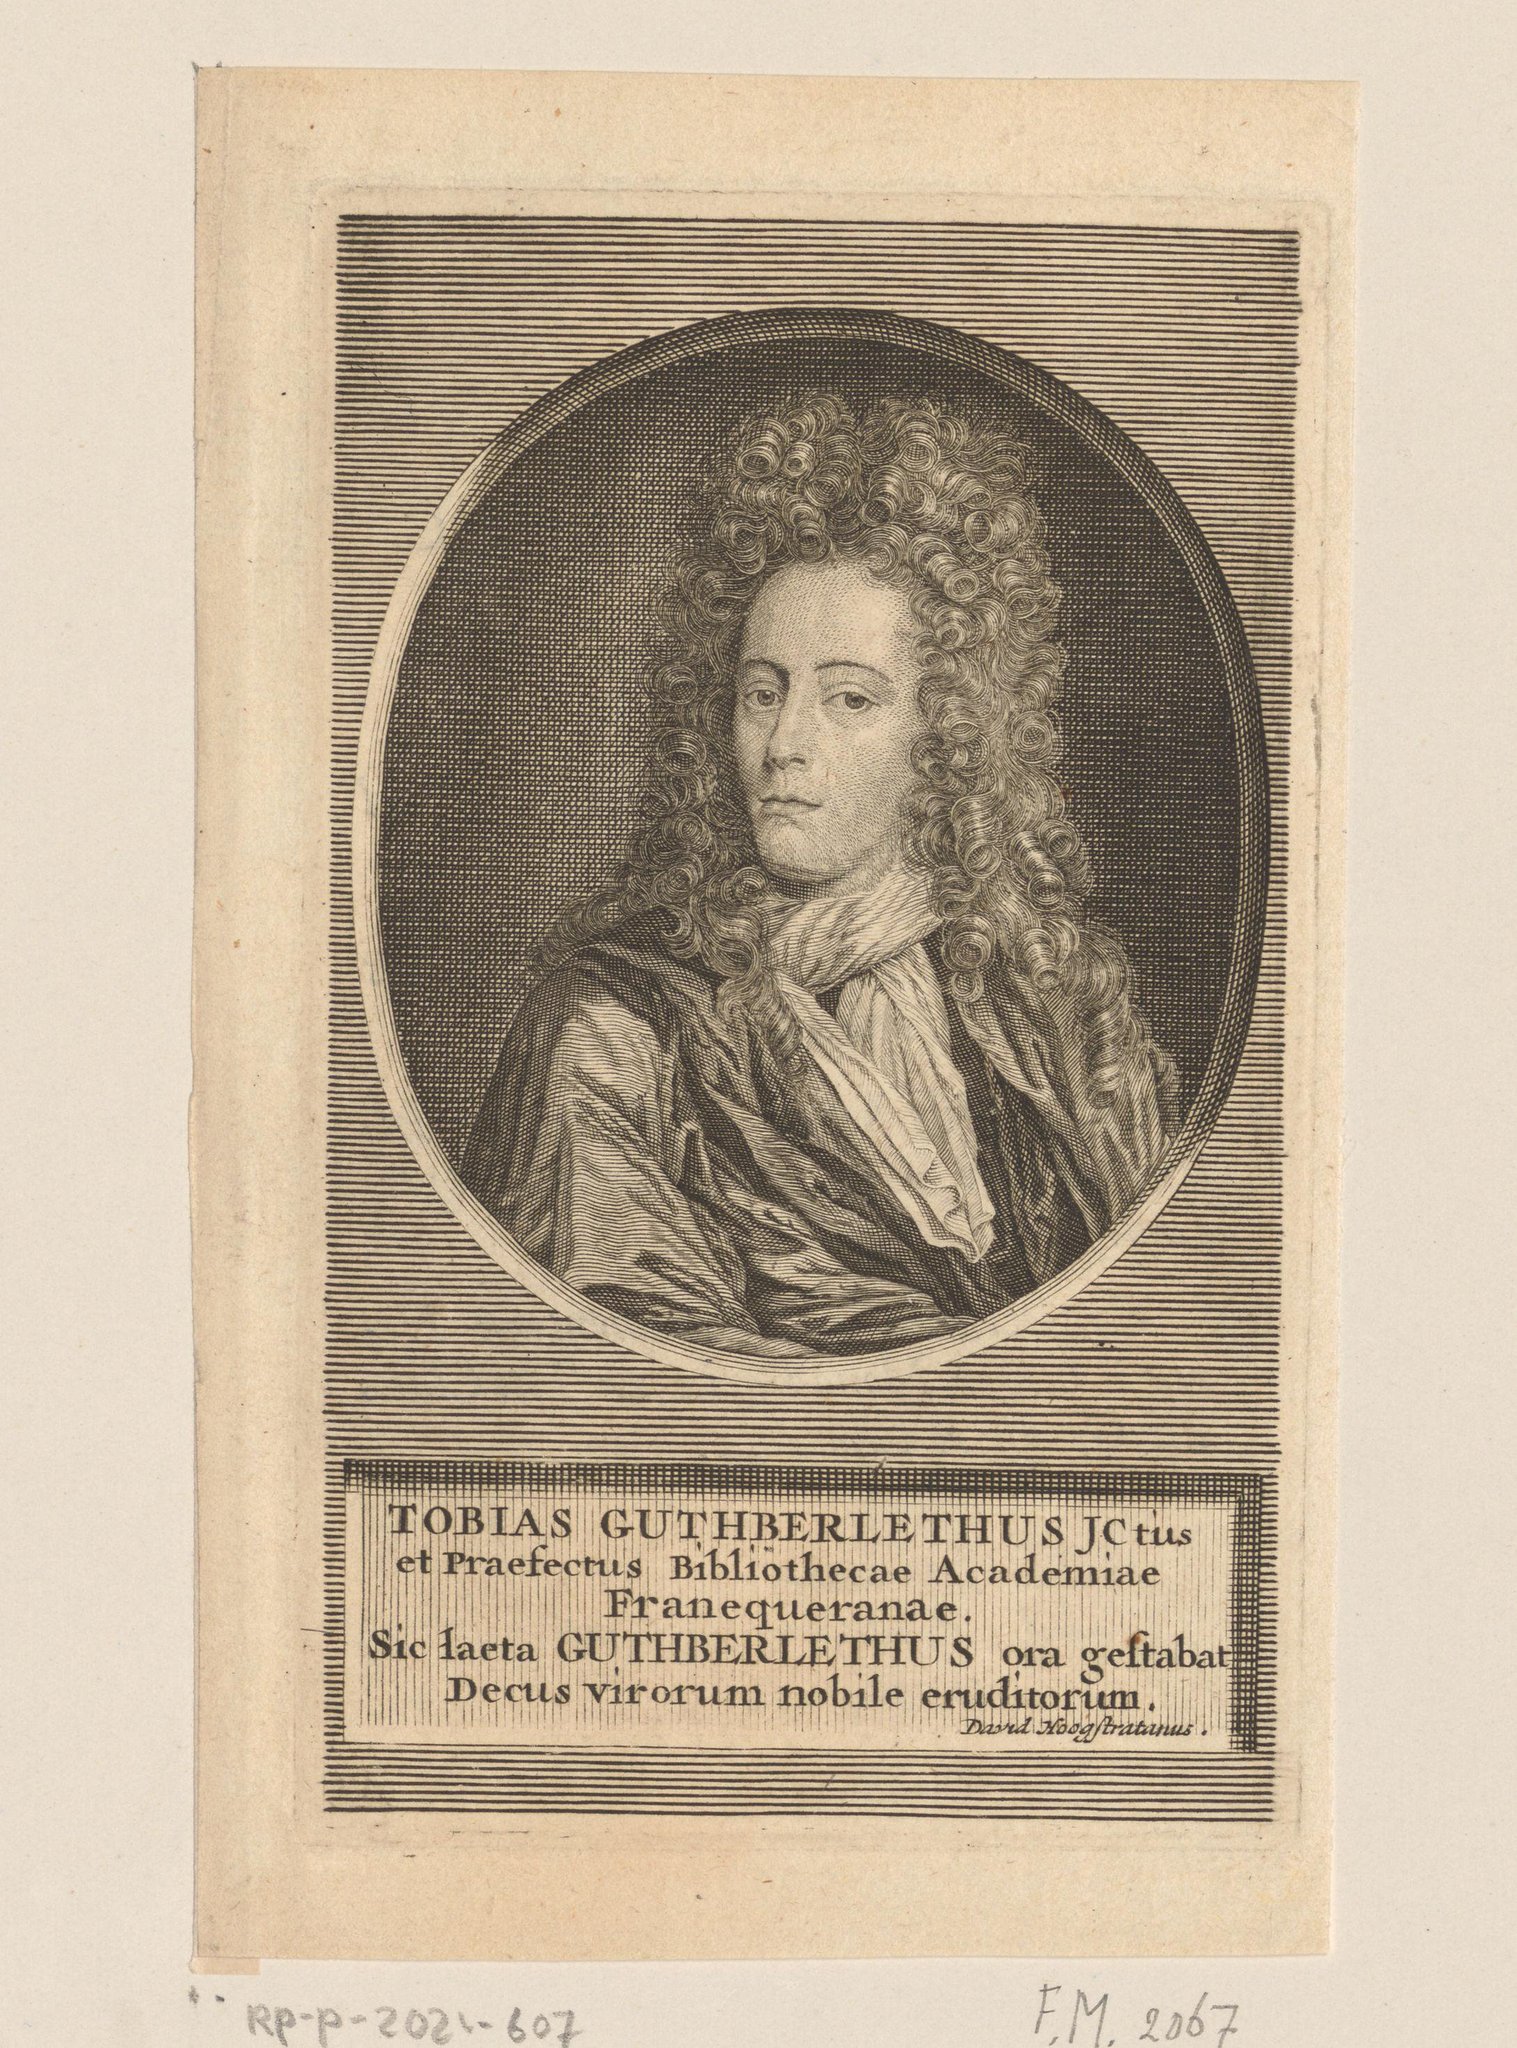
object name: print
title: Portret van Tobias Gutberleth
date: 1704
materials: paper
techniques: engraving, letterpress printing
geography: franeker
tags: historical persons, professor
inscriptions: collector's mark: Lugt 2228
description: Prent uit: Gutberleth, Tobias. Opuscula, I. De saliis martis sacerdotibus apud Romanos (...). Franeker: François Halma, 1704.